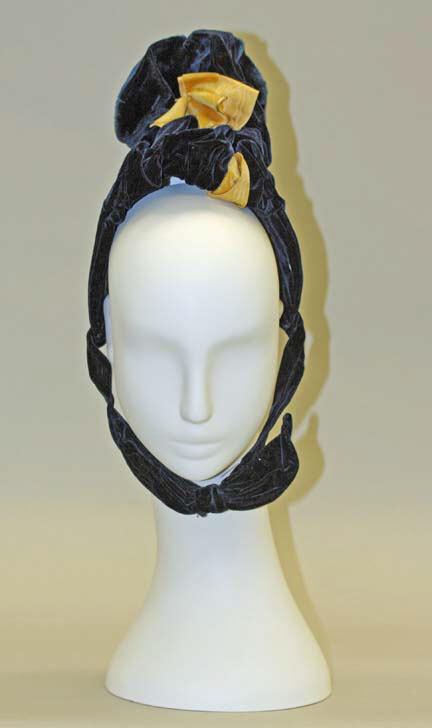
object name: bonnet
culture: american or european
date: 1887-1890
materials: silk